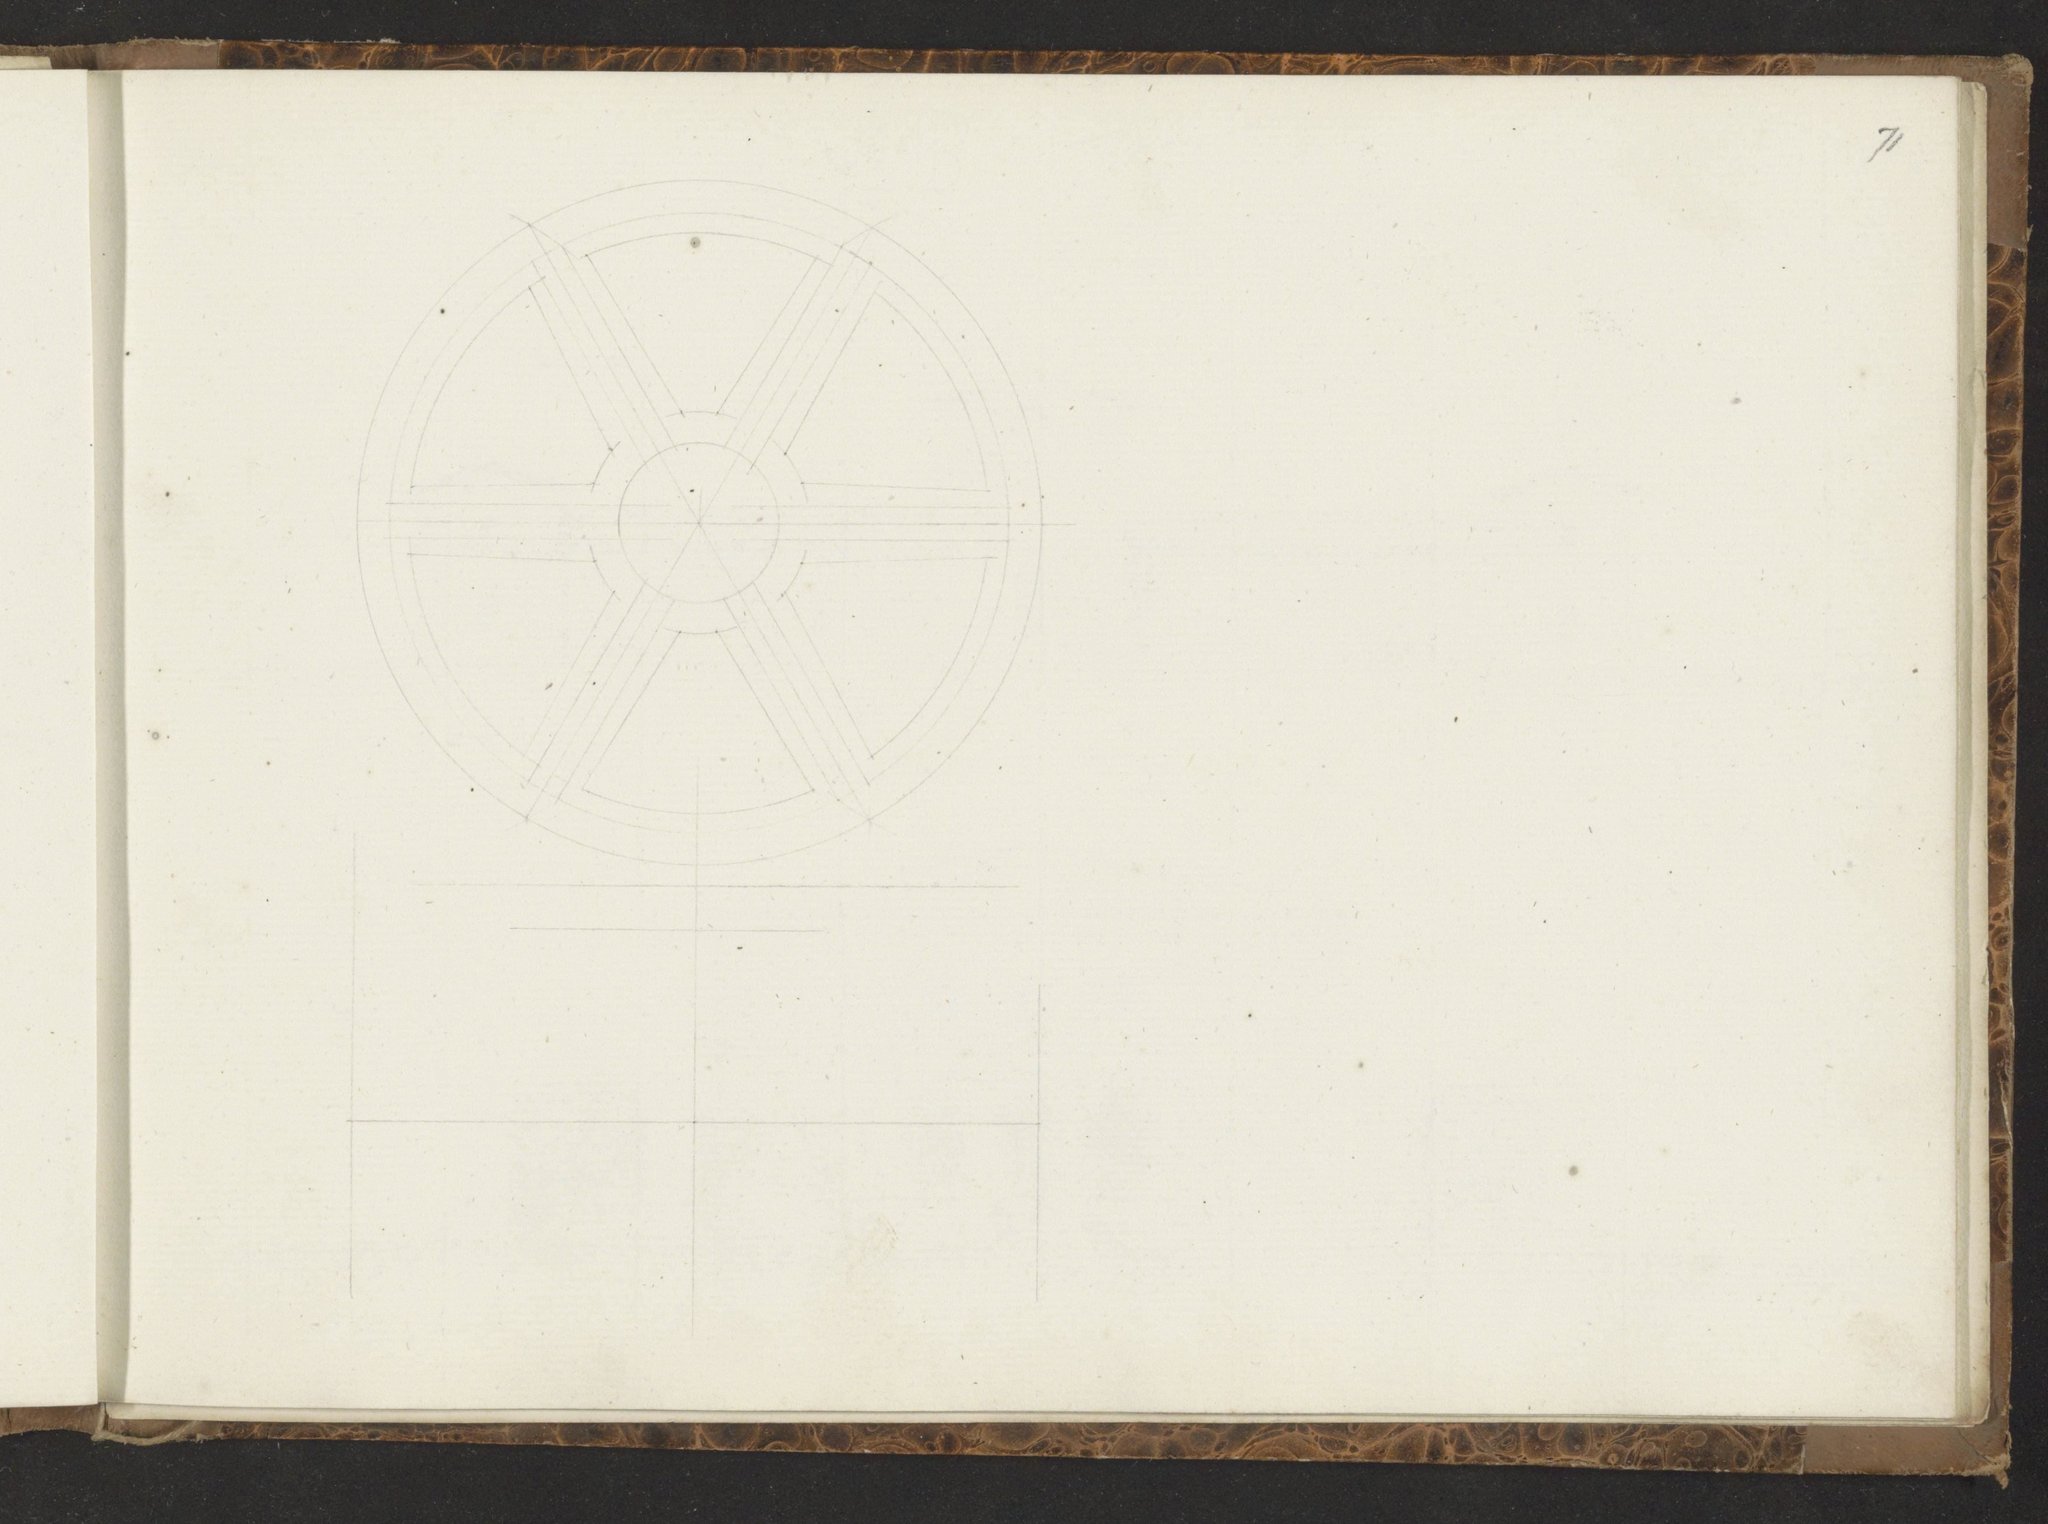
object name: sketchbook leaf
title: Rad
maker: willem springer jr.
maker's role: draughtsman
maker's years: 1815-1907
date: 1825-1907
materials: paper, pencil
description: Pagina 71 uit een schetsboek met 86 pagina's.